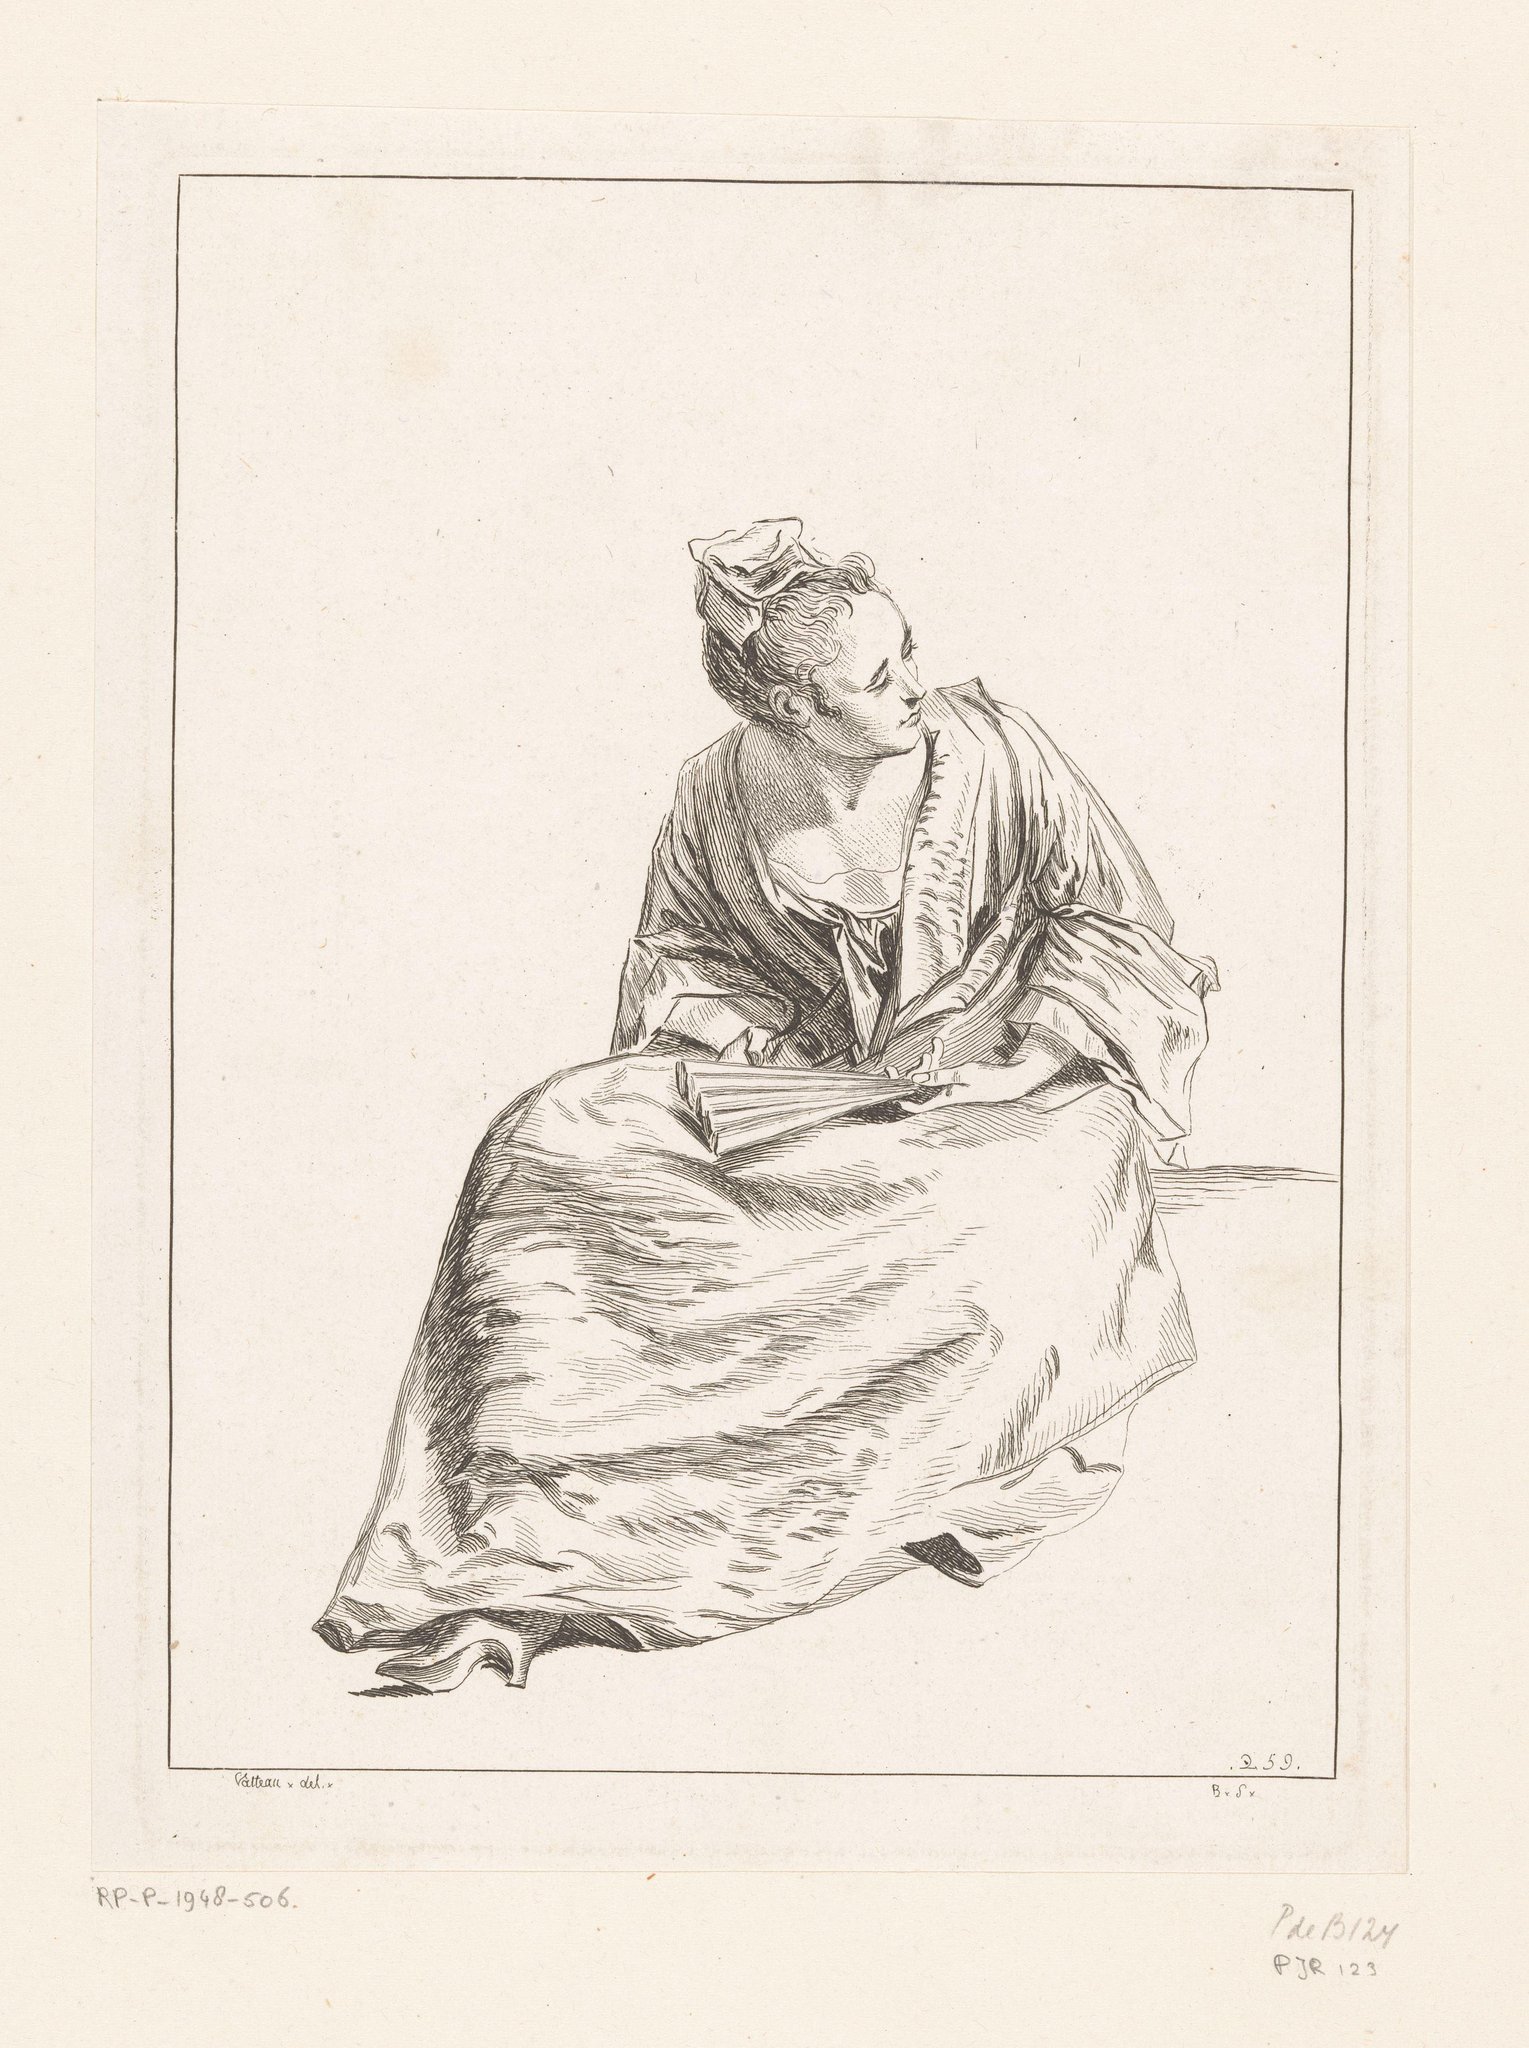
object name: print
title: Figures de différents caractères, de Paysages (...)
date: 1728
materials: paper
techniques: etching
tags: sitting figure - aa - female human figure, fan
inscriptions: collector's mark: Lugt 2228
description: Maakt deel uit van een serie van 351 prenten, naar tekeningen door Watteau, getiteld 'Figures de différents caractères, de Paysages, et d'Etudes dessinées d'après nature par Antoine Watteau peintre du Roy en son Académie Royale de Peinture et Sculpture Gravées à l'Eau forte par les plus habiles Peintres et Graveurs du temps, tirées des plus beaux cabinets de Paris'. De serie werd geëtst door vijftien verschillende kunstenaars en bestaat uit twee delen. Het eerste deel werd uitgegeven in 1726 en de tweede in 1728.